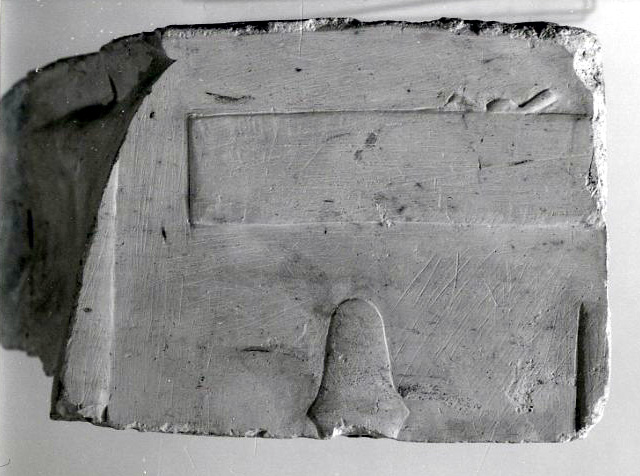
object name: relief fragment, tomb of meketre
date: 1981-1975 BCE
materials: limestone, paint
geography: egypt